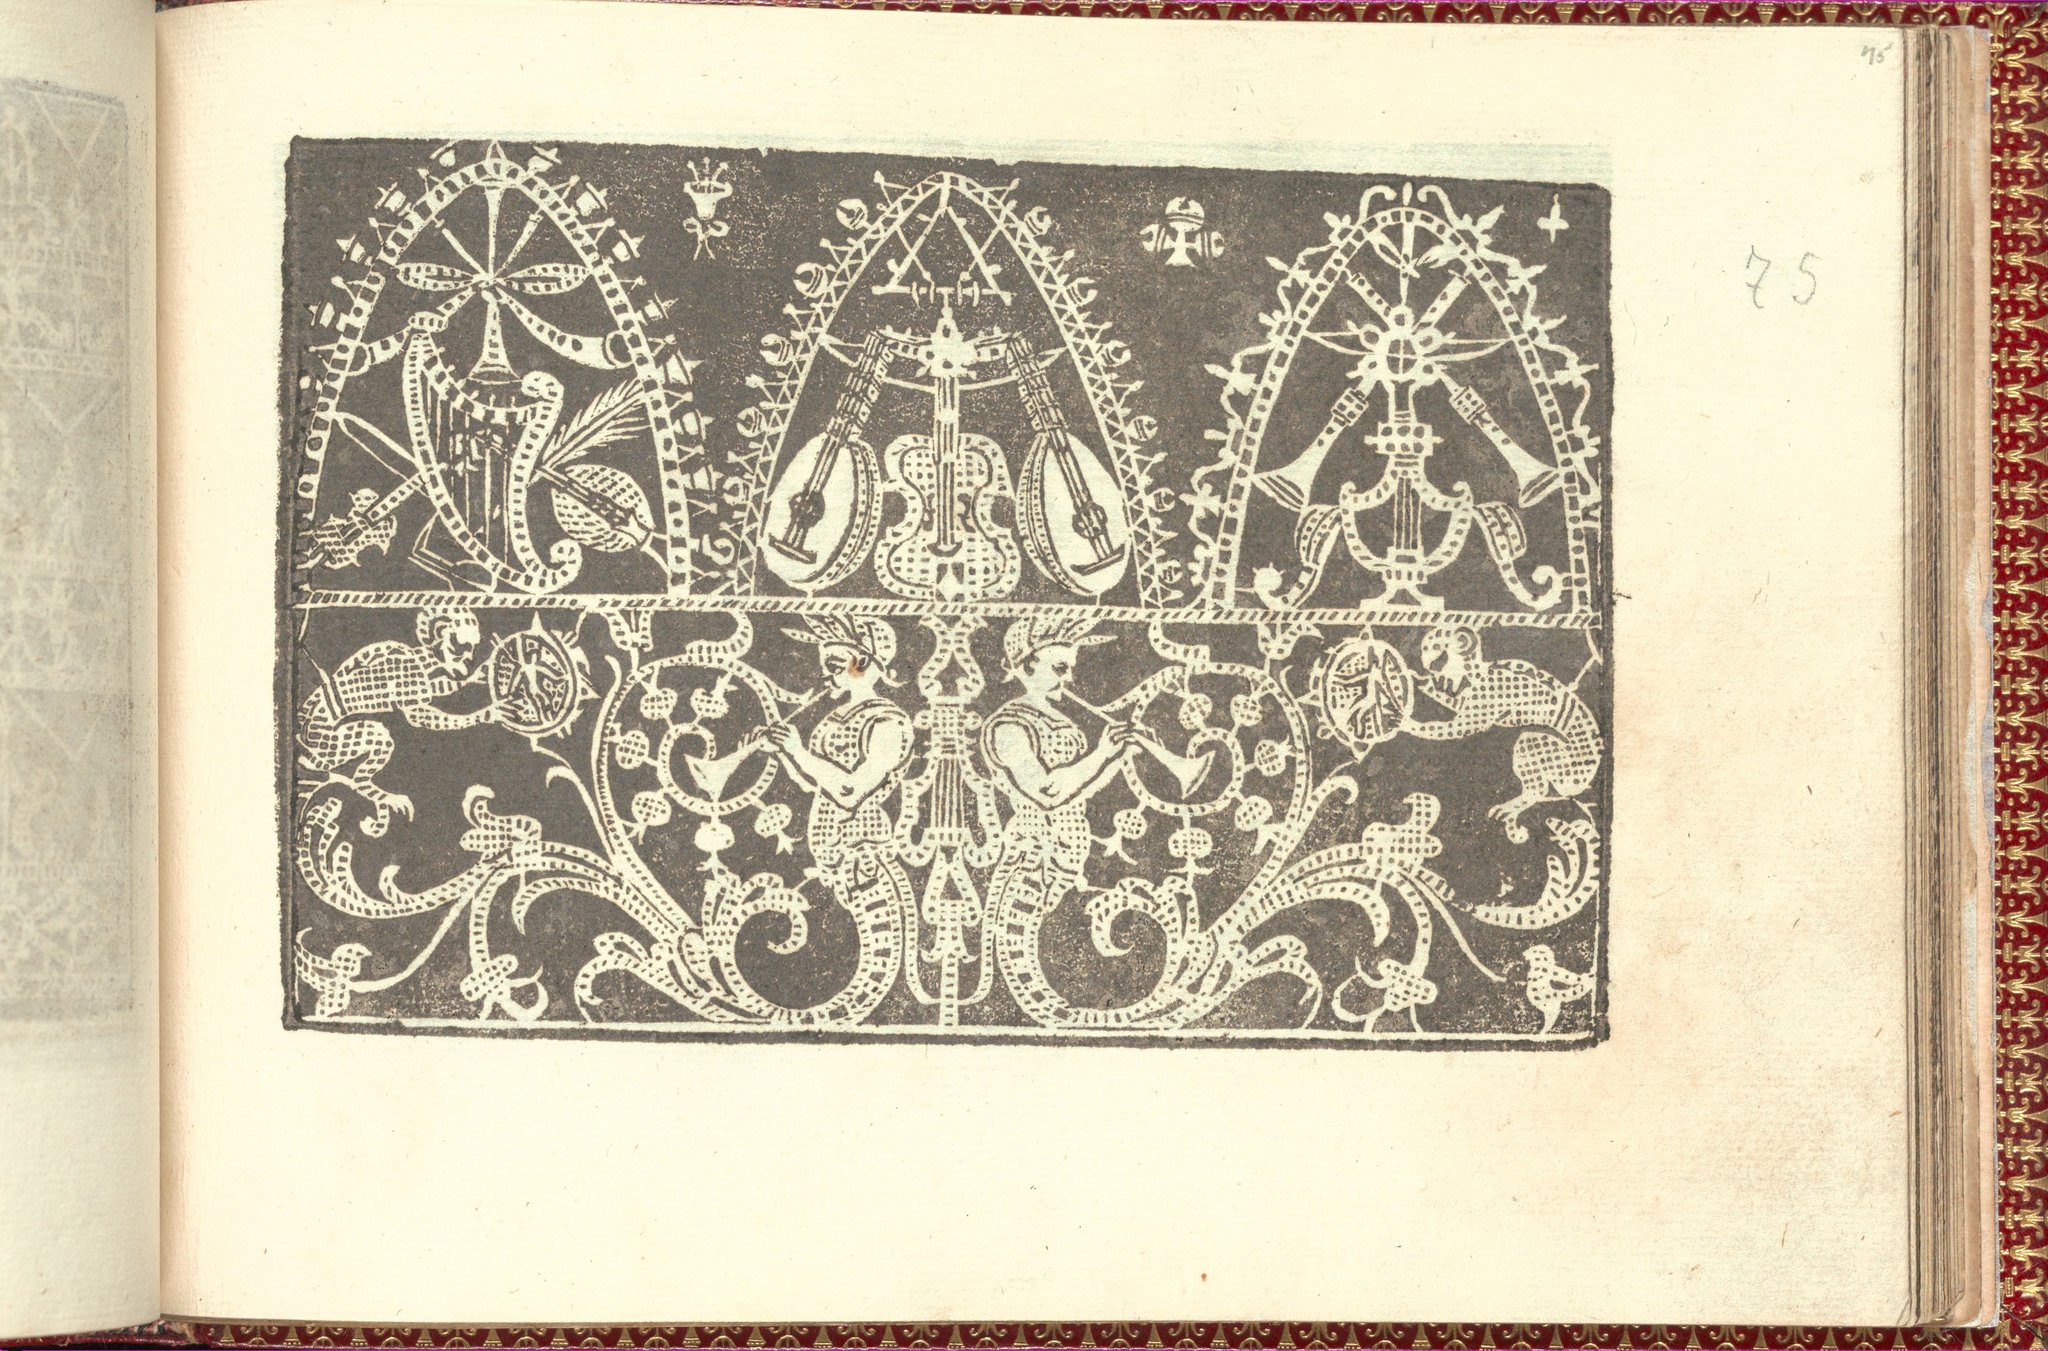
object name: book print ornament architecture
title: Corona delle Nobili et Virtuose Donne: Libro I-IV, page 75 (recto)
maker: cesare vecellio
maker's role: publisher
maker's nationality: italian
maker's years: 1521-1601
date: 1601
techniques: woodcut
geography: italy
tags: men,harps,horns,violins